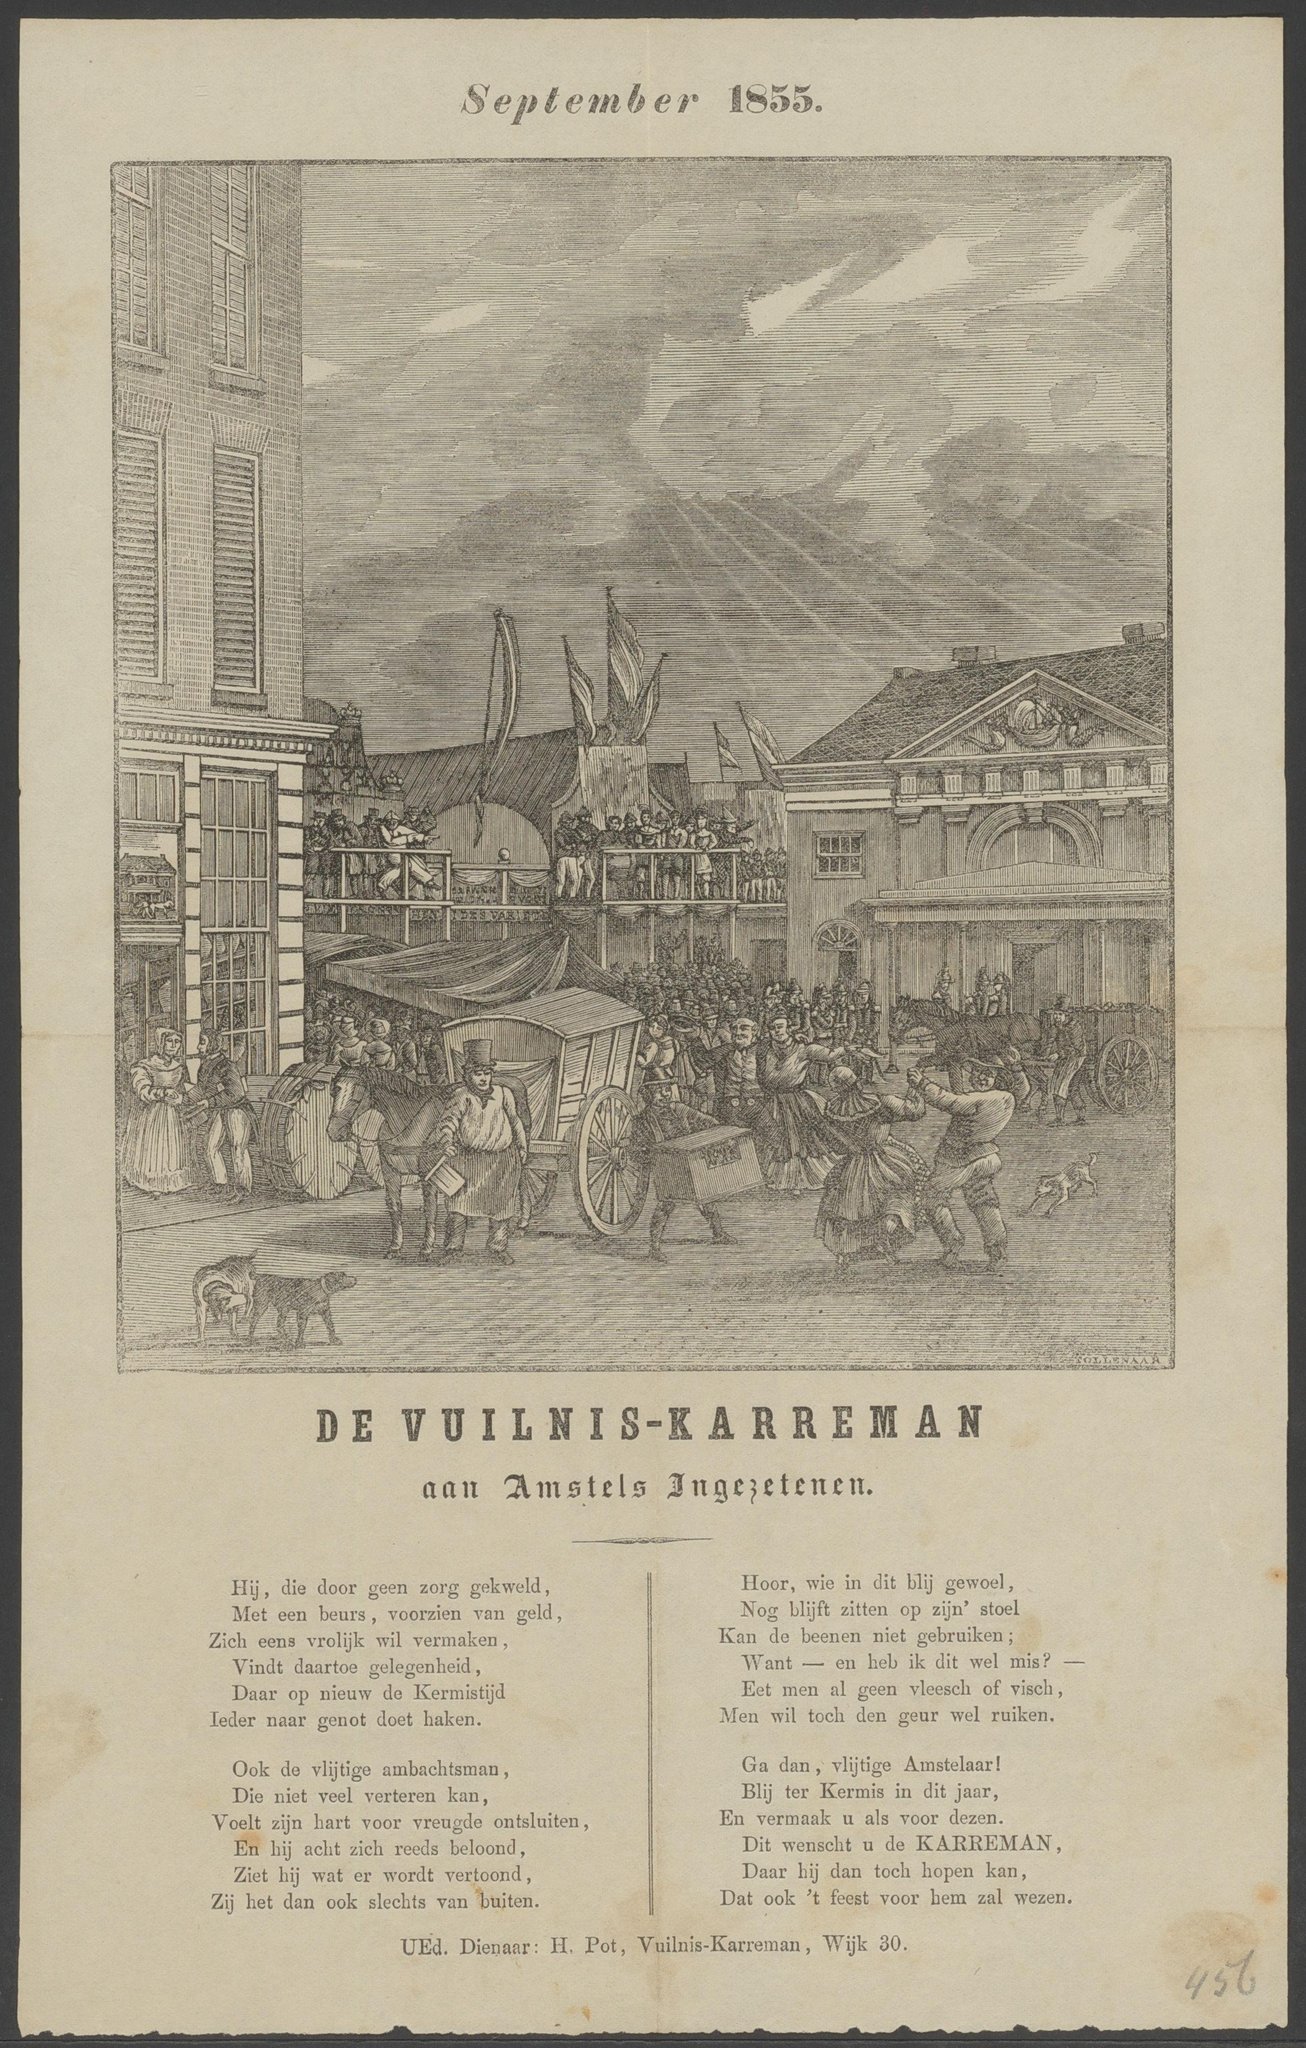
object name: fair print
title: De Vuilnis-Karreman aan Amstels Ingezetenen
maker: dirk wijbrand tollenaar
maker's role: print maker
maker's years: 1808-1858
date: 1855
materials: paper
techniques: letterpress printing, engraving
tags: street, garbage collection, amsterdam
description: Kermisprent van de Amsterdamse vuilnismannen voor het jaar 1855. Gezicht op de kermis op de Botermarkt met de oude Waag. Op de markt twee vuilniskarren. Met gedicht in twee kolommen. Van de vuilniskarman in de wijk no. 30: H. Pot. Onderwerpsrubrieken binnen de Atlas Zeden en Gewoonten: Zeden en gewoonten in engeren zin, Volksleven, Volksbladen, Nieuwjaars- en Kerstwenschen, Amsterdam.